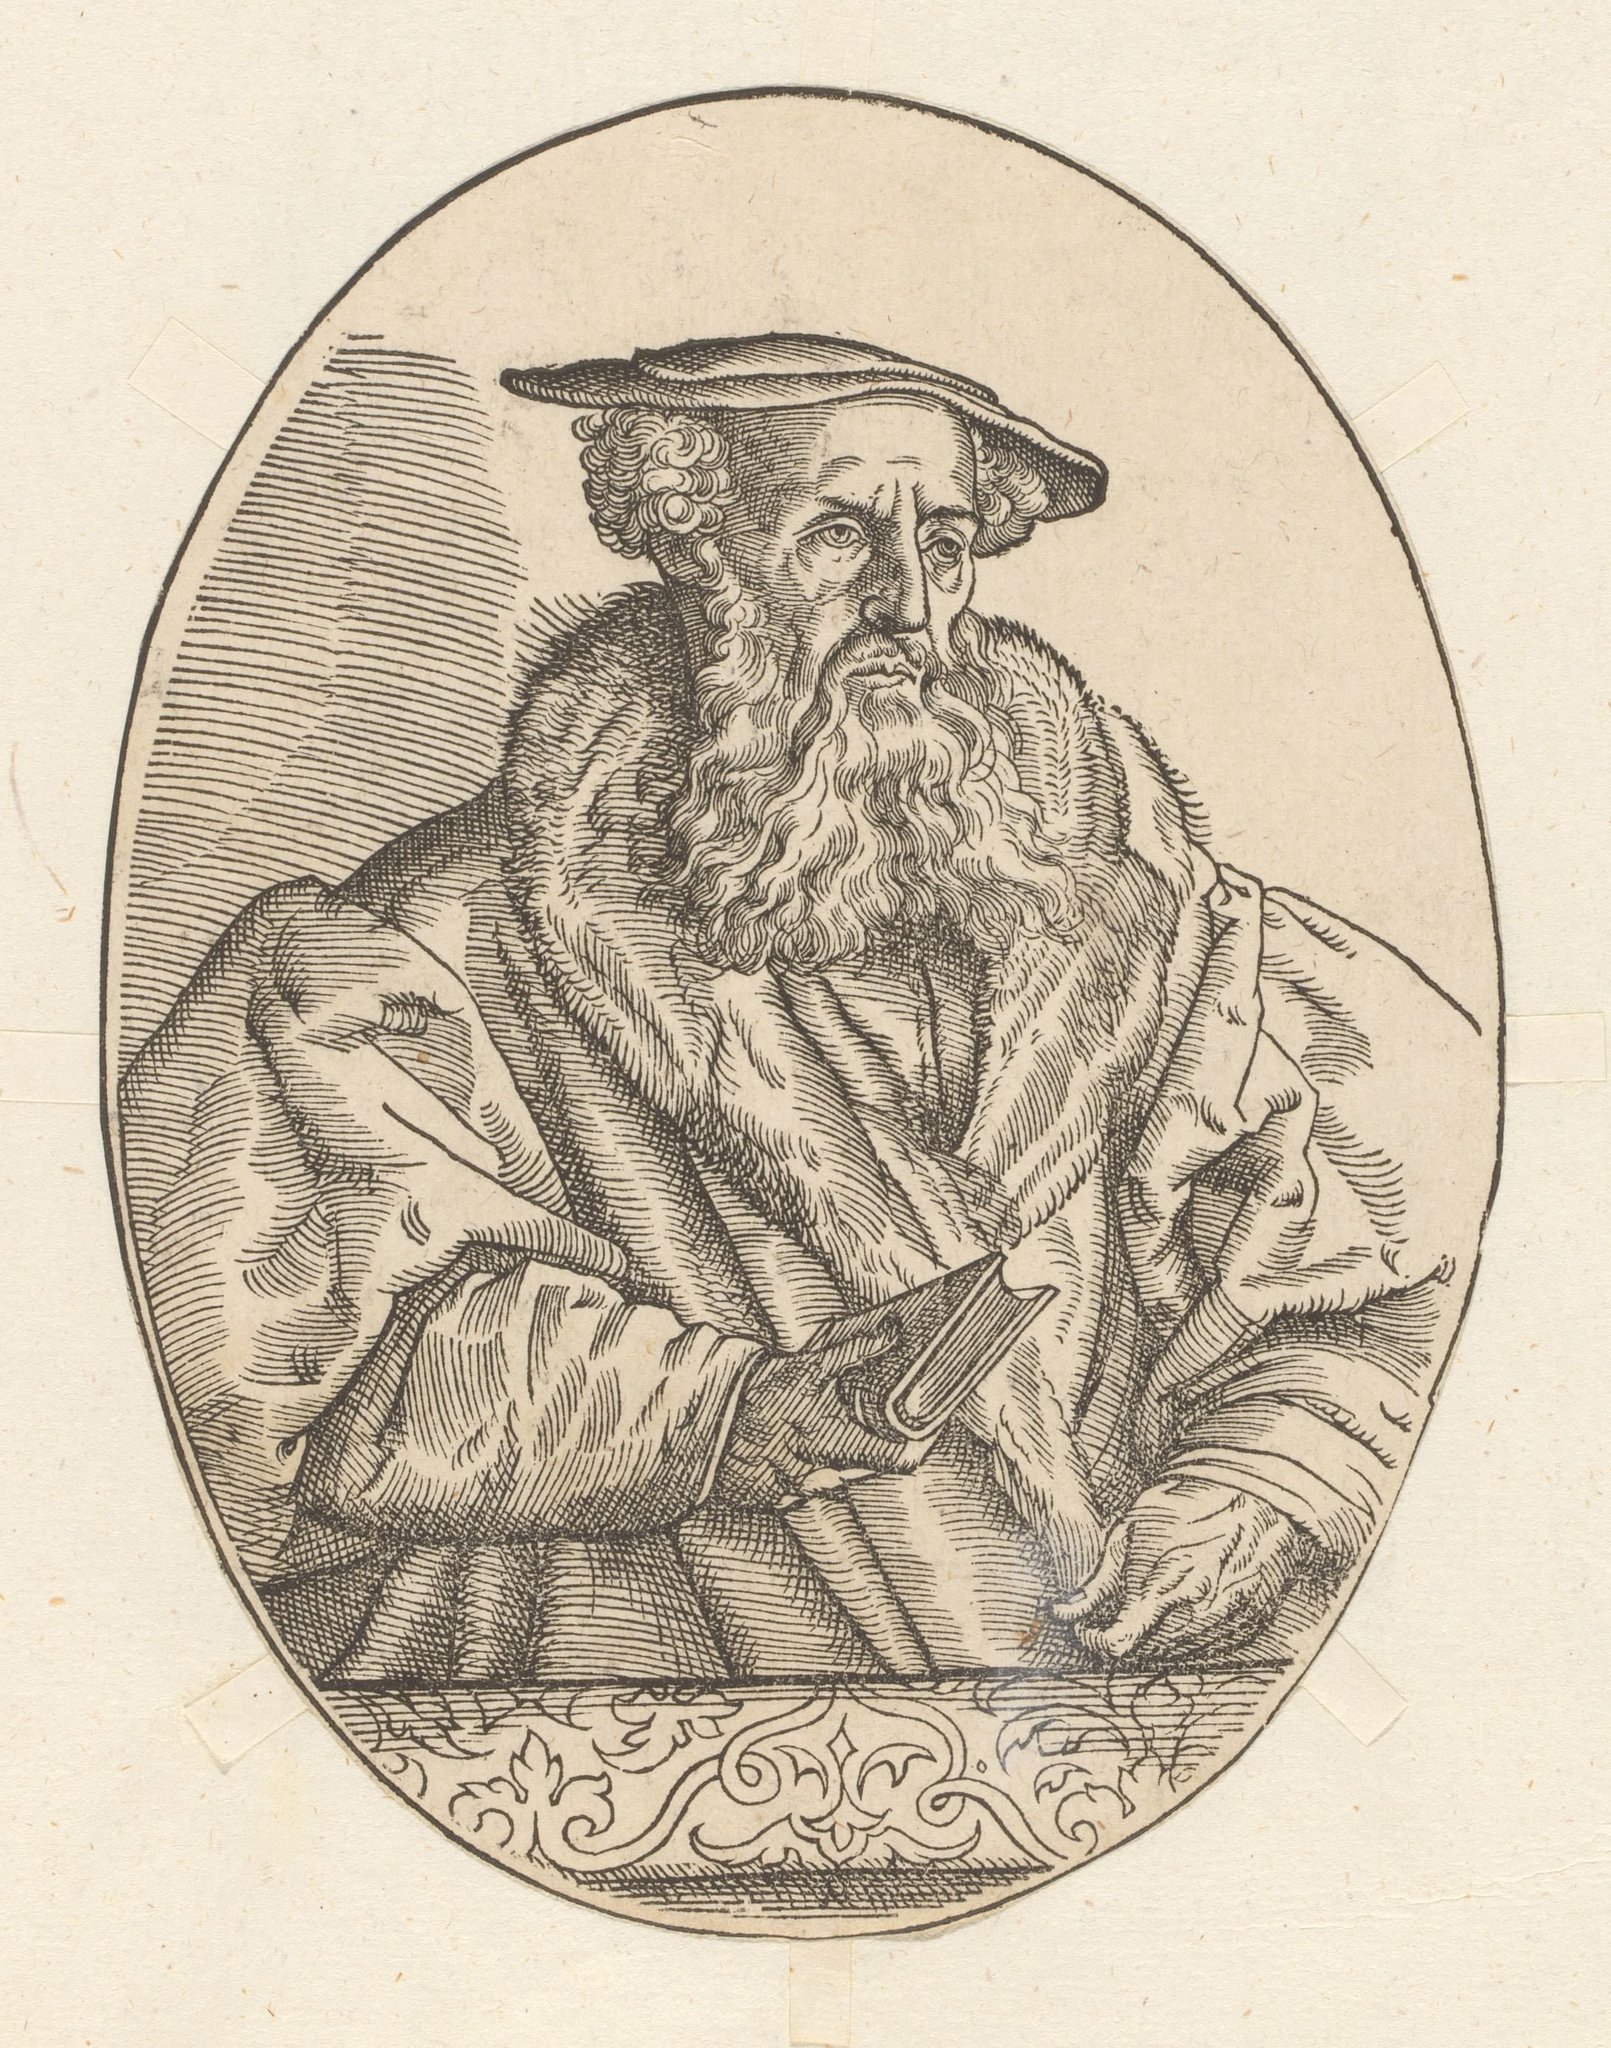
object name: album leaf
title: Portret van Heinrich Bullinger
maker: Anonymous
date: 1549-1584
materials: paper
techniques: woodcut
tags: historical persons, portrait of a writer